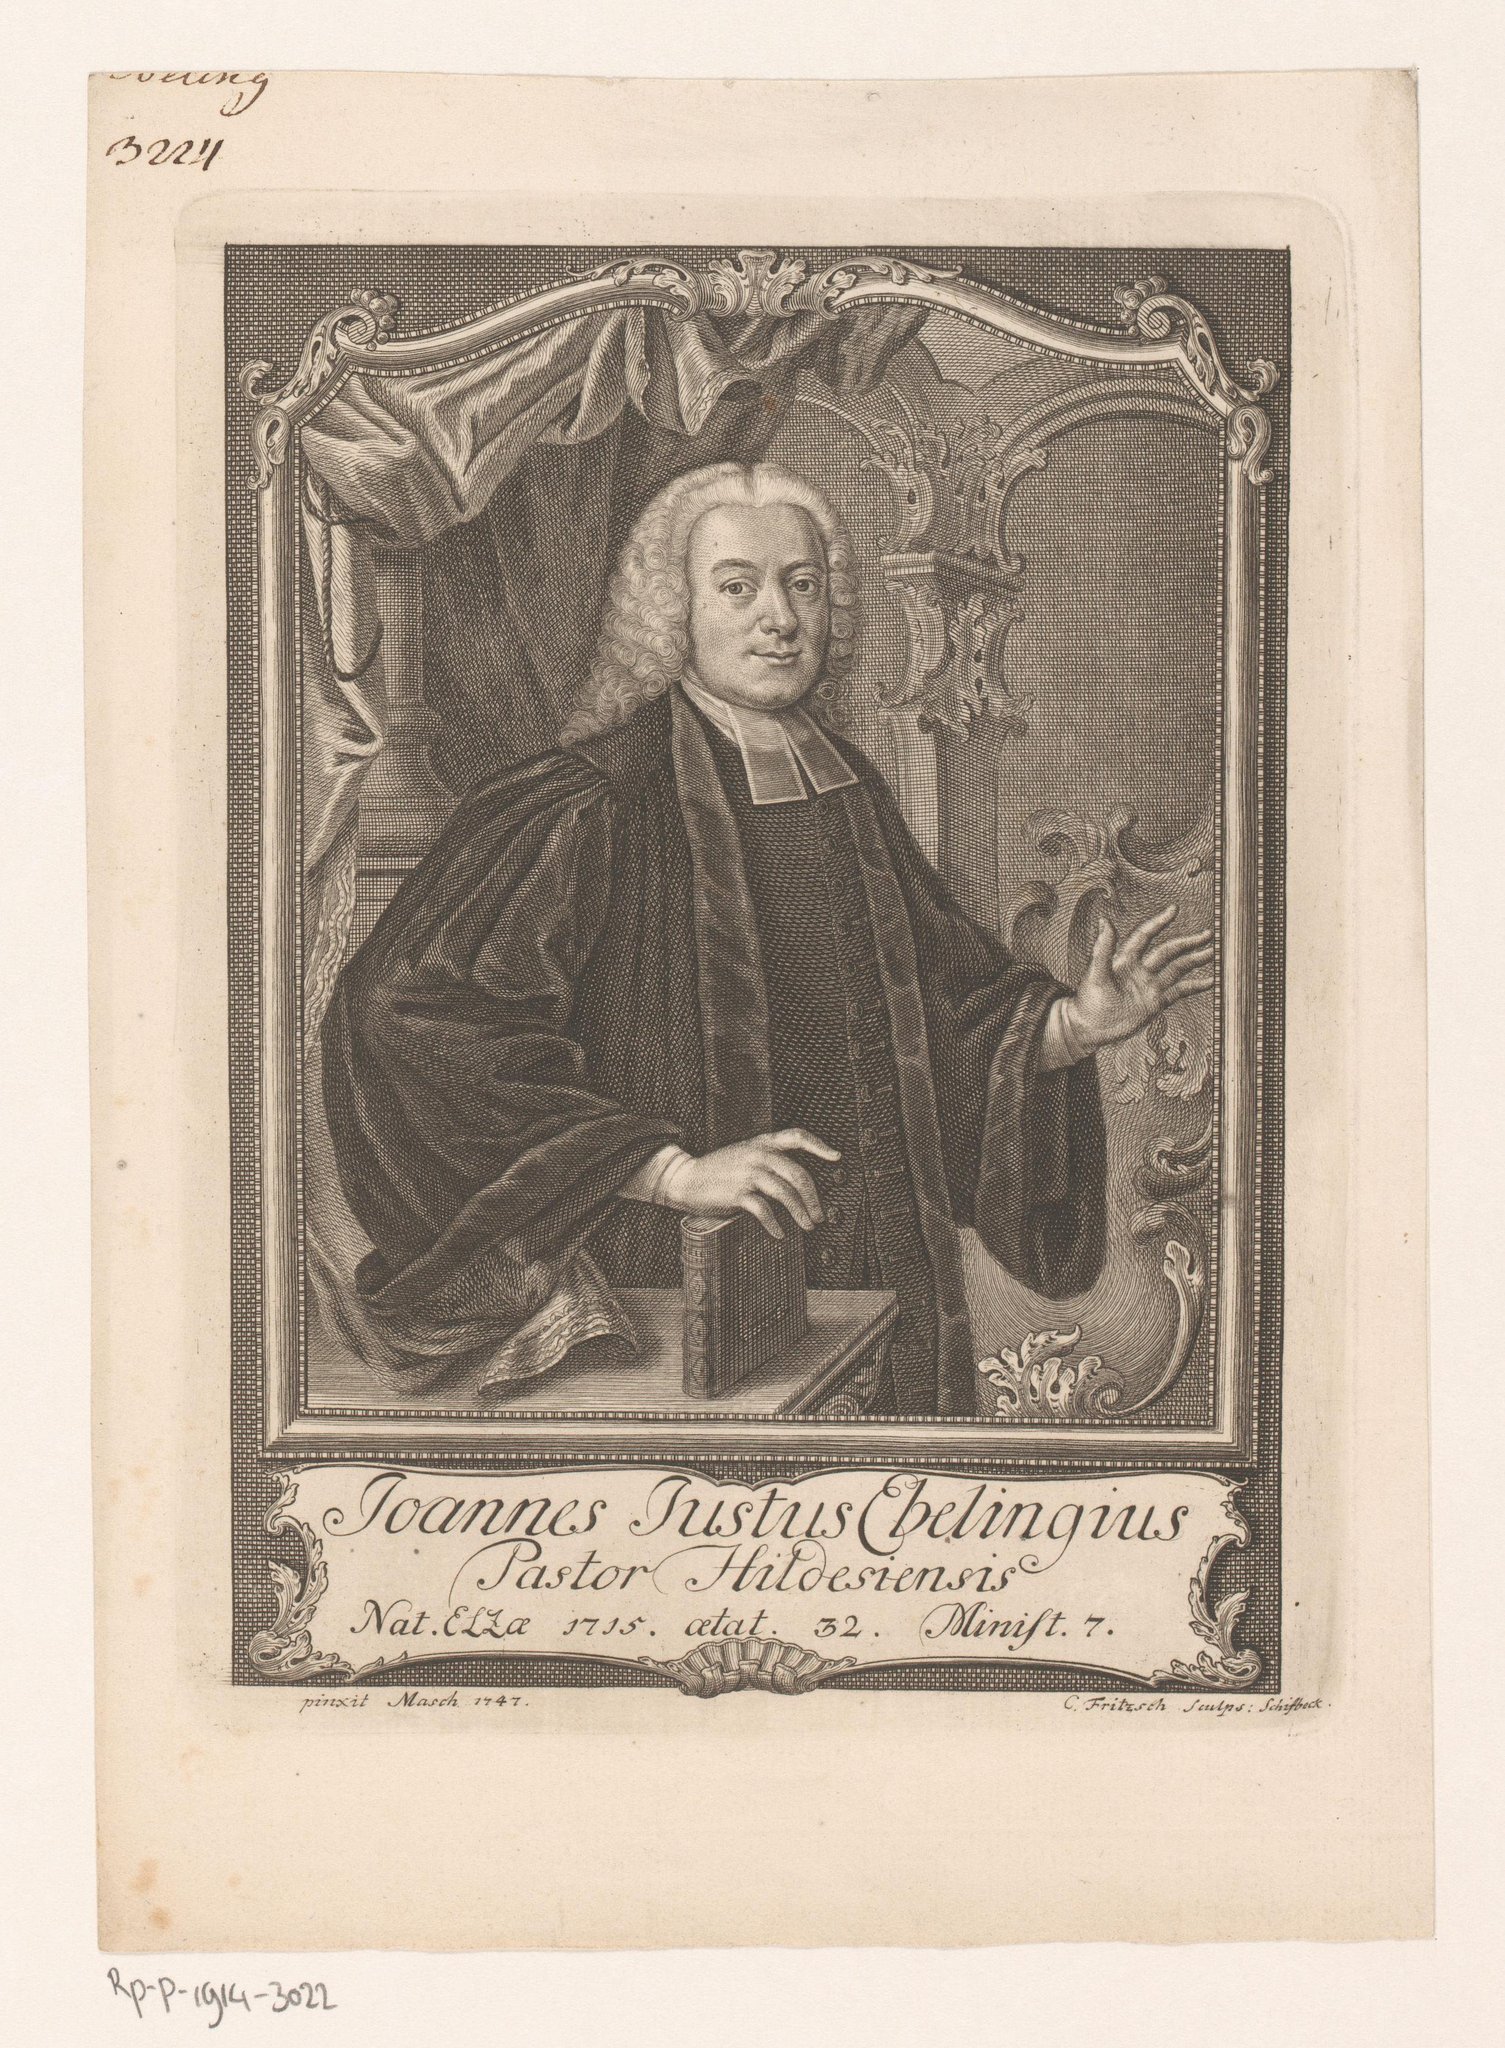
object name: print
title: Portret van Johann Justus Ebeling op 32-jarige leeftijd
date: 1747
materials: paper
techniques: engraving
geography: schiffbeck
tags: rocaille ornament, historical persons, book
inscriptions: collector's mark: Lugt 2228